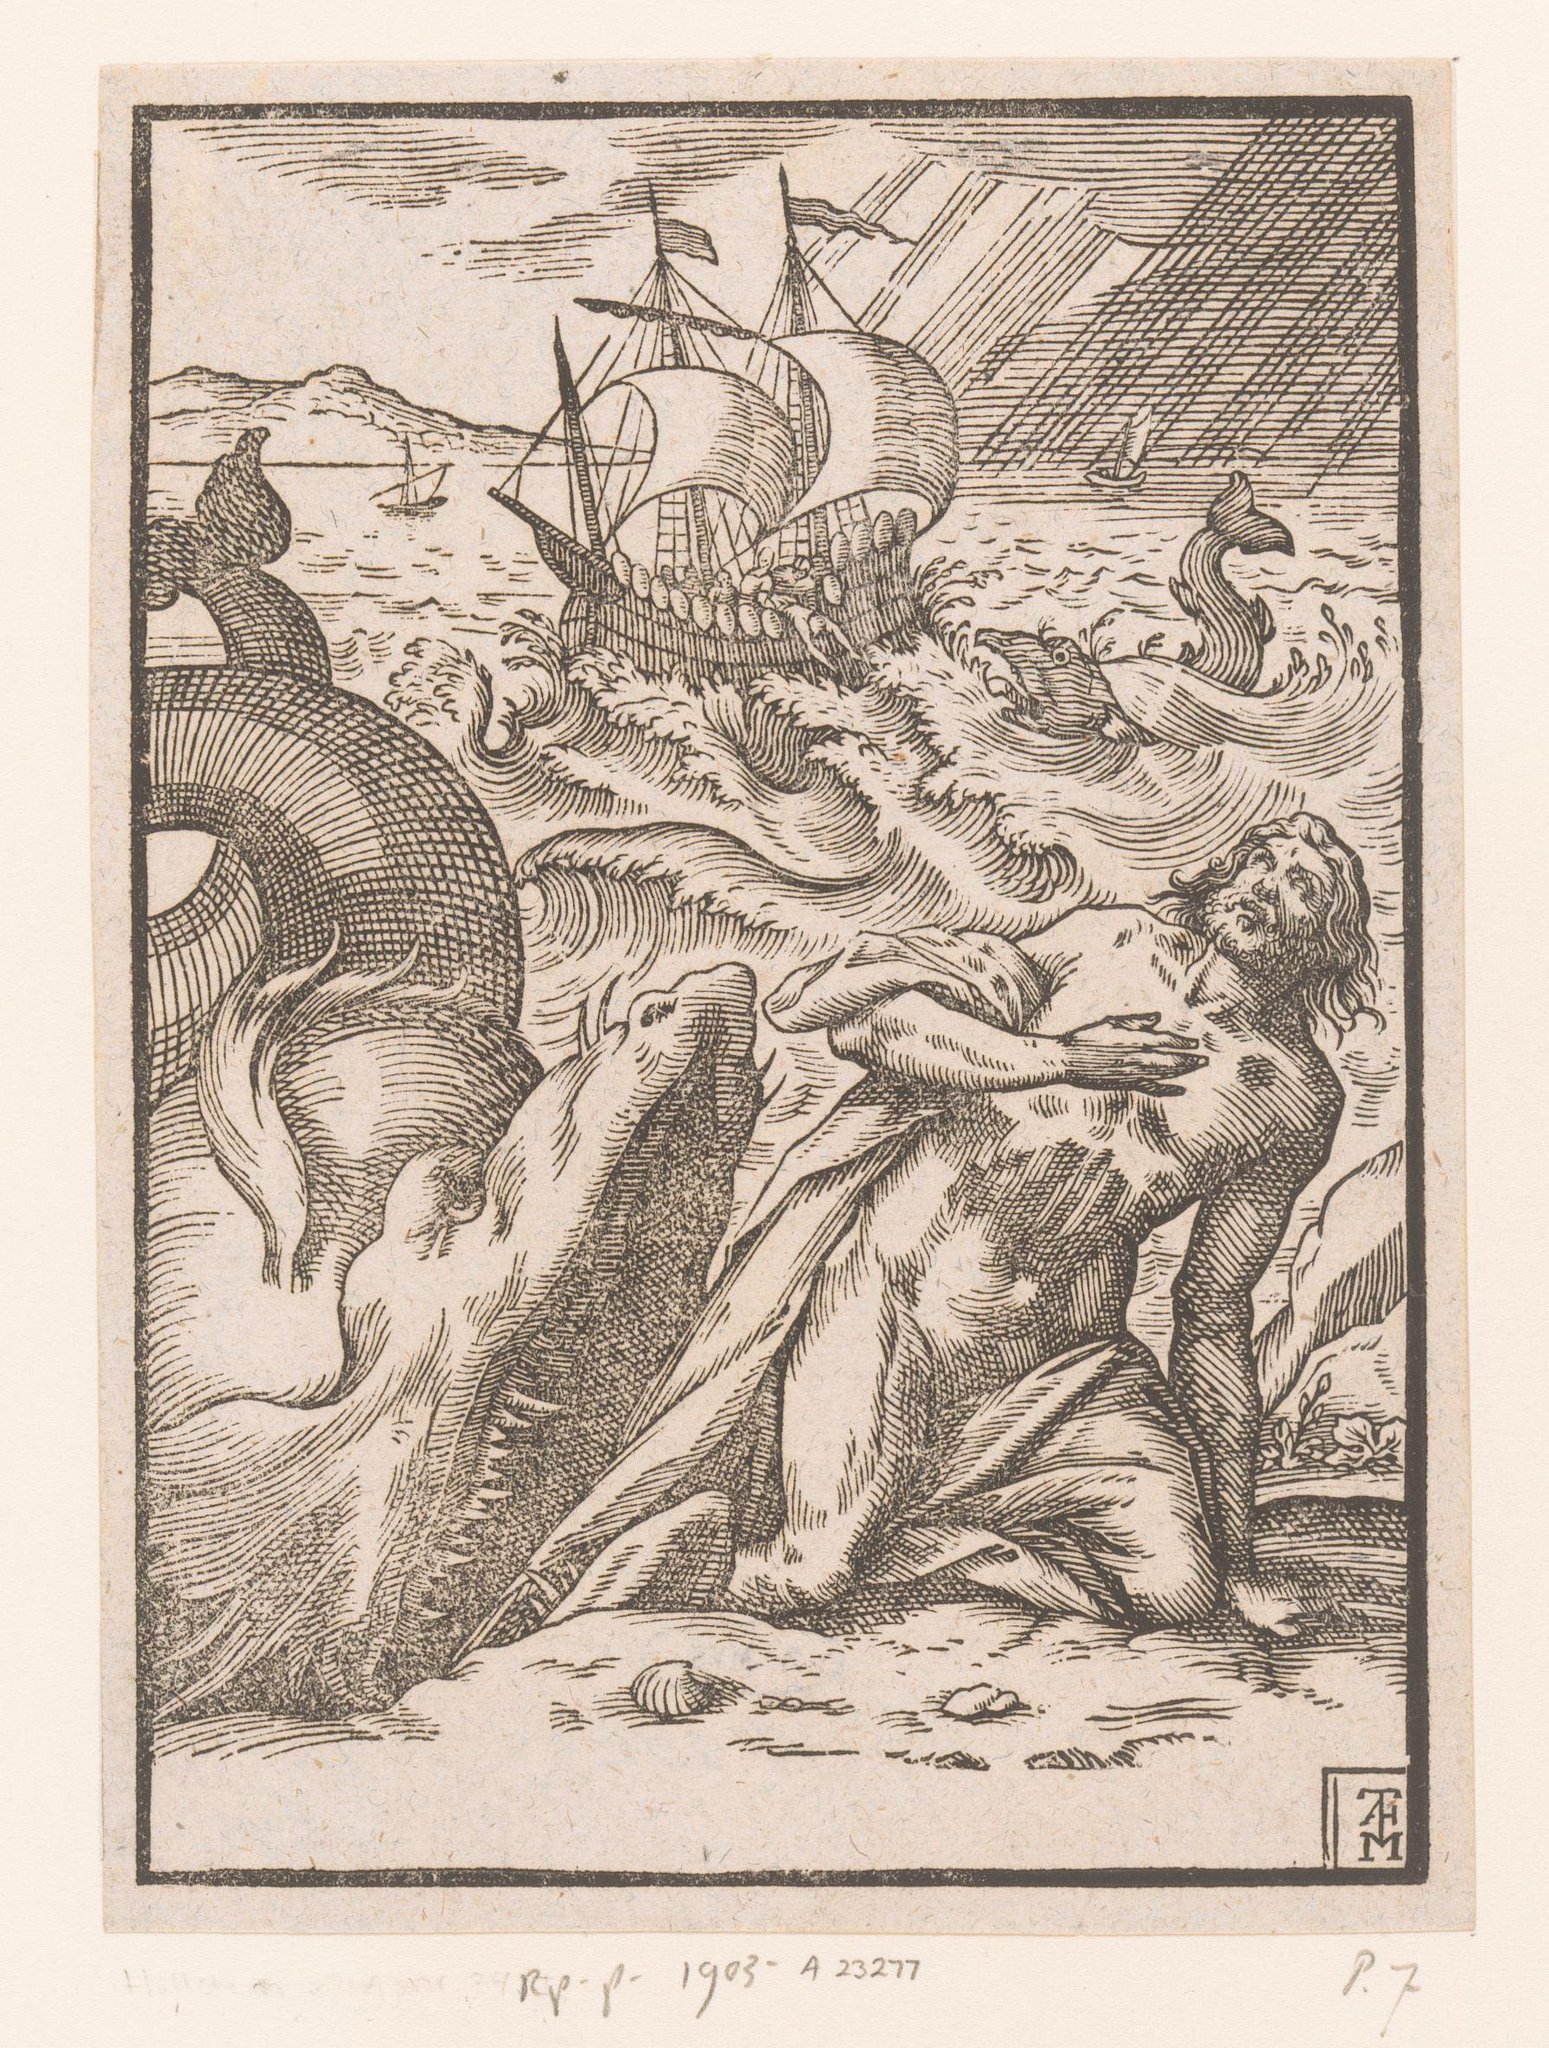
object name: print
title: Leven van Christus, evangeslisten en heiligen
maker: marx anton hannas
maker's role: print maker, publisher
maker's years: 1600-1676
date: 1610-1676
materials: paper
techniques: woodcut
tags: after a three-day sojourn in the belly of the monster jonah is cast on dry land; jonah may be shown nude and bald-headed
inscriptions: collector's mark: Lugt 2228